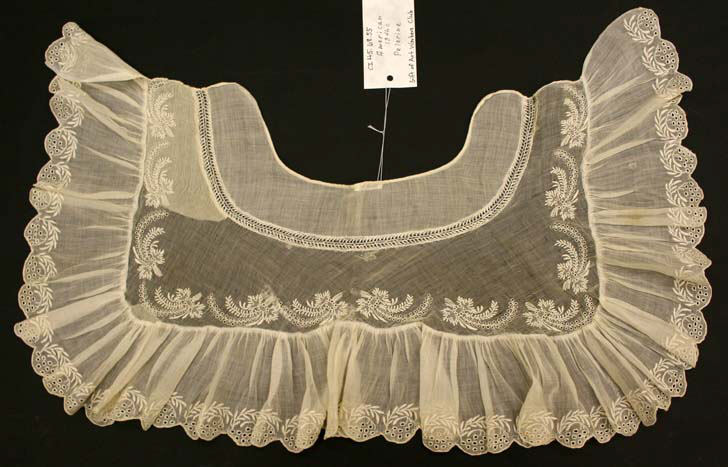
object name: collar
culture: american or european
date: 1700-1945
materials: cotton